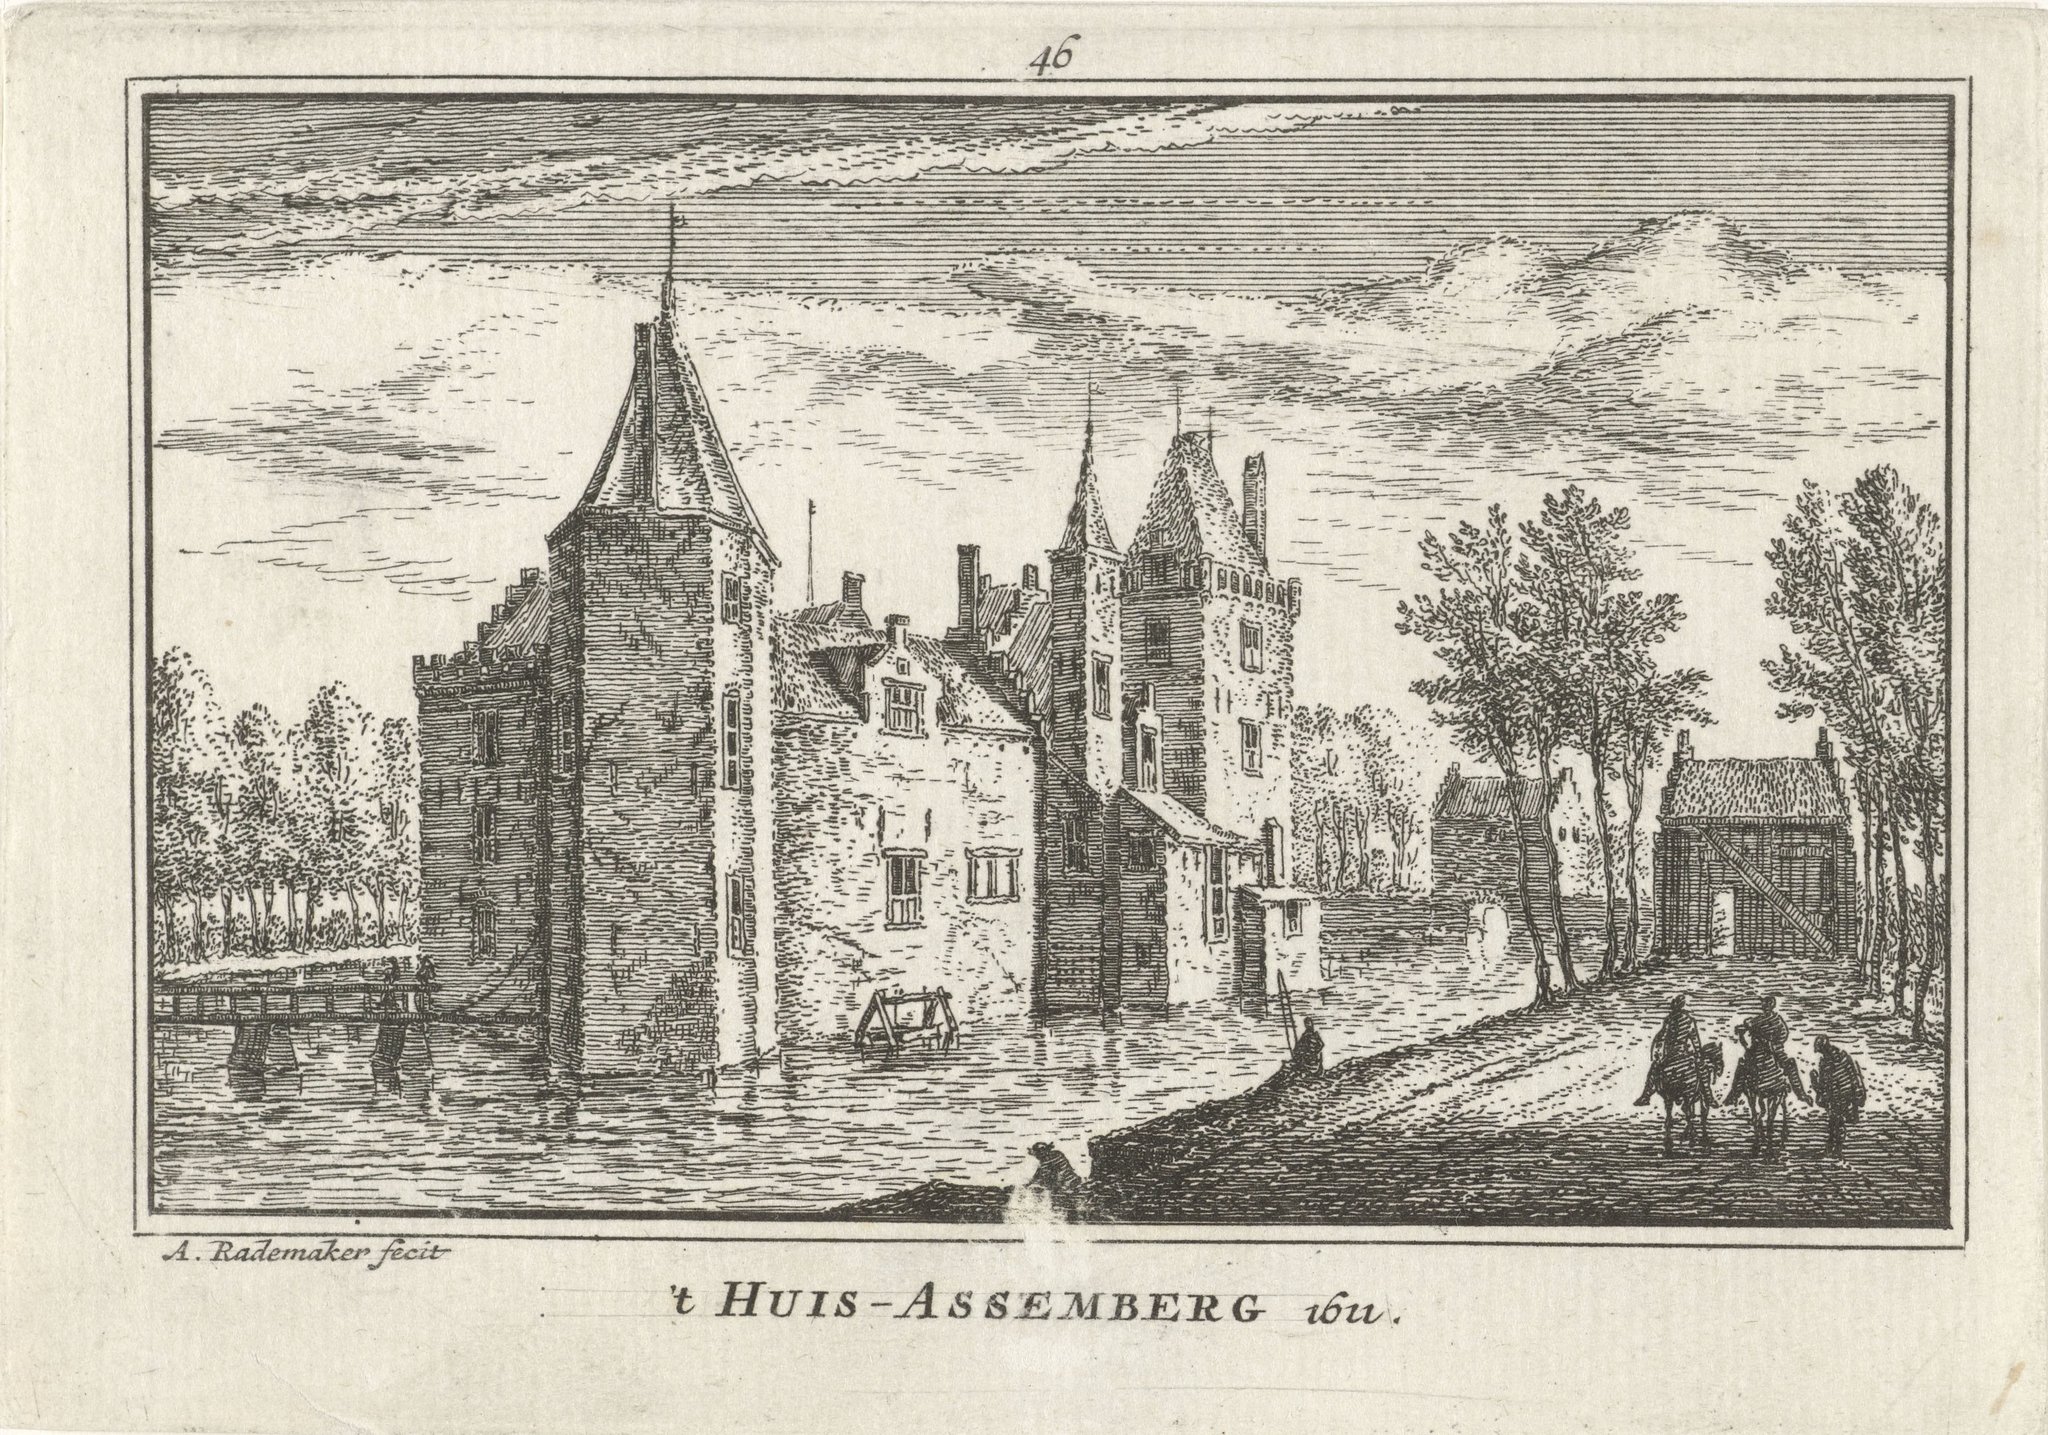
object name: print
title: Gezicht op Slot Assumburg, 1611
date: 1727-1733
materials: paper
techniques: etching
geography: amsterdam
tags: castle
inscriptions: collector's mark: Lugt 2228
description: Illustratie uit: Abraham Rademaker, Matthaeus Brouërius van Niedek, Isaac Le Long, Kabinet van Nederlandsche en Kleefsche outheden en (...) voorname stads- en landgebouwen, Willem Barents en Antoni Schoonenburg: Amsterdam, 1727-1733, ill. nr. 46.